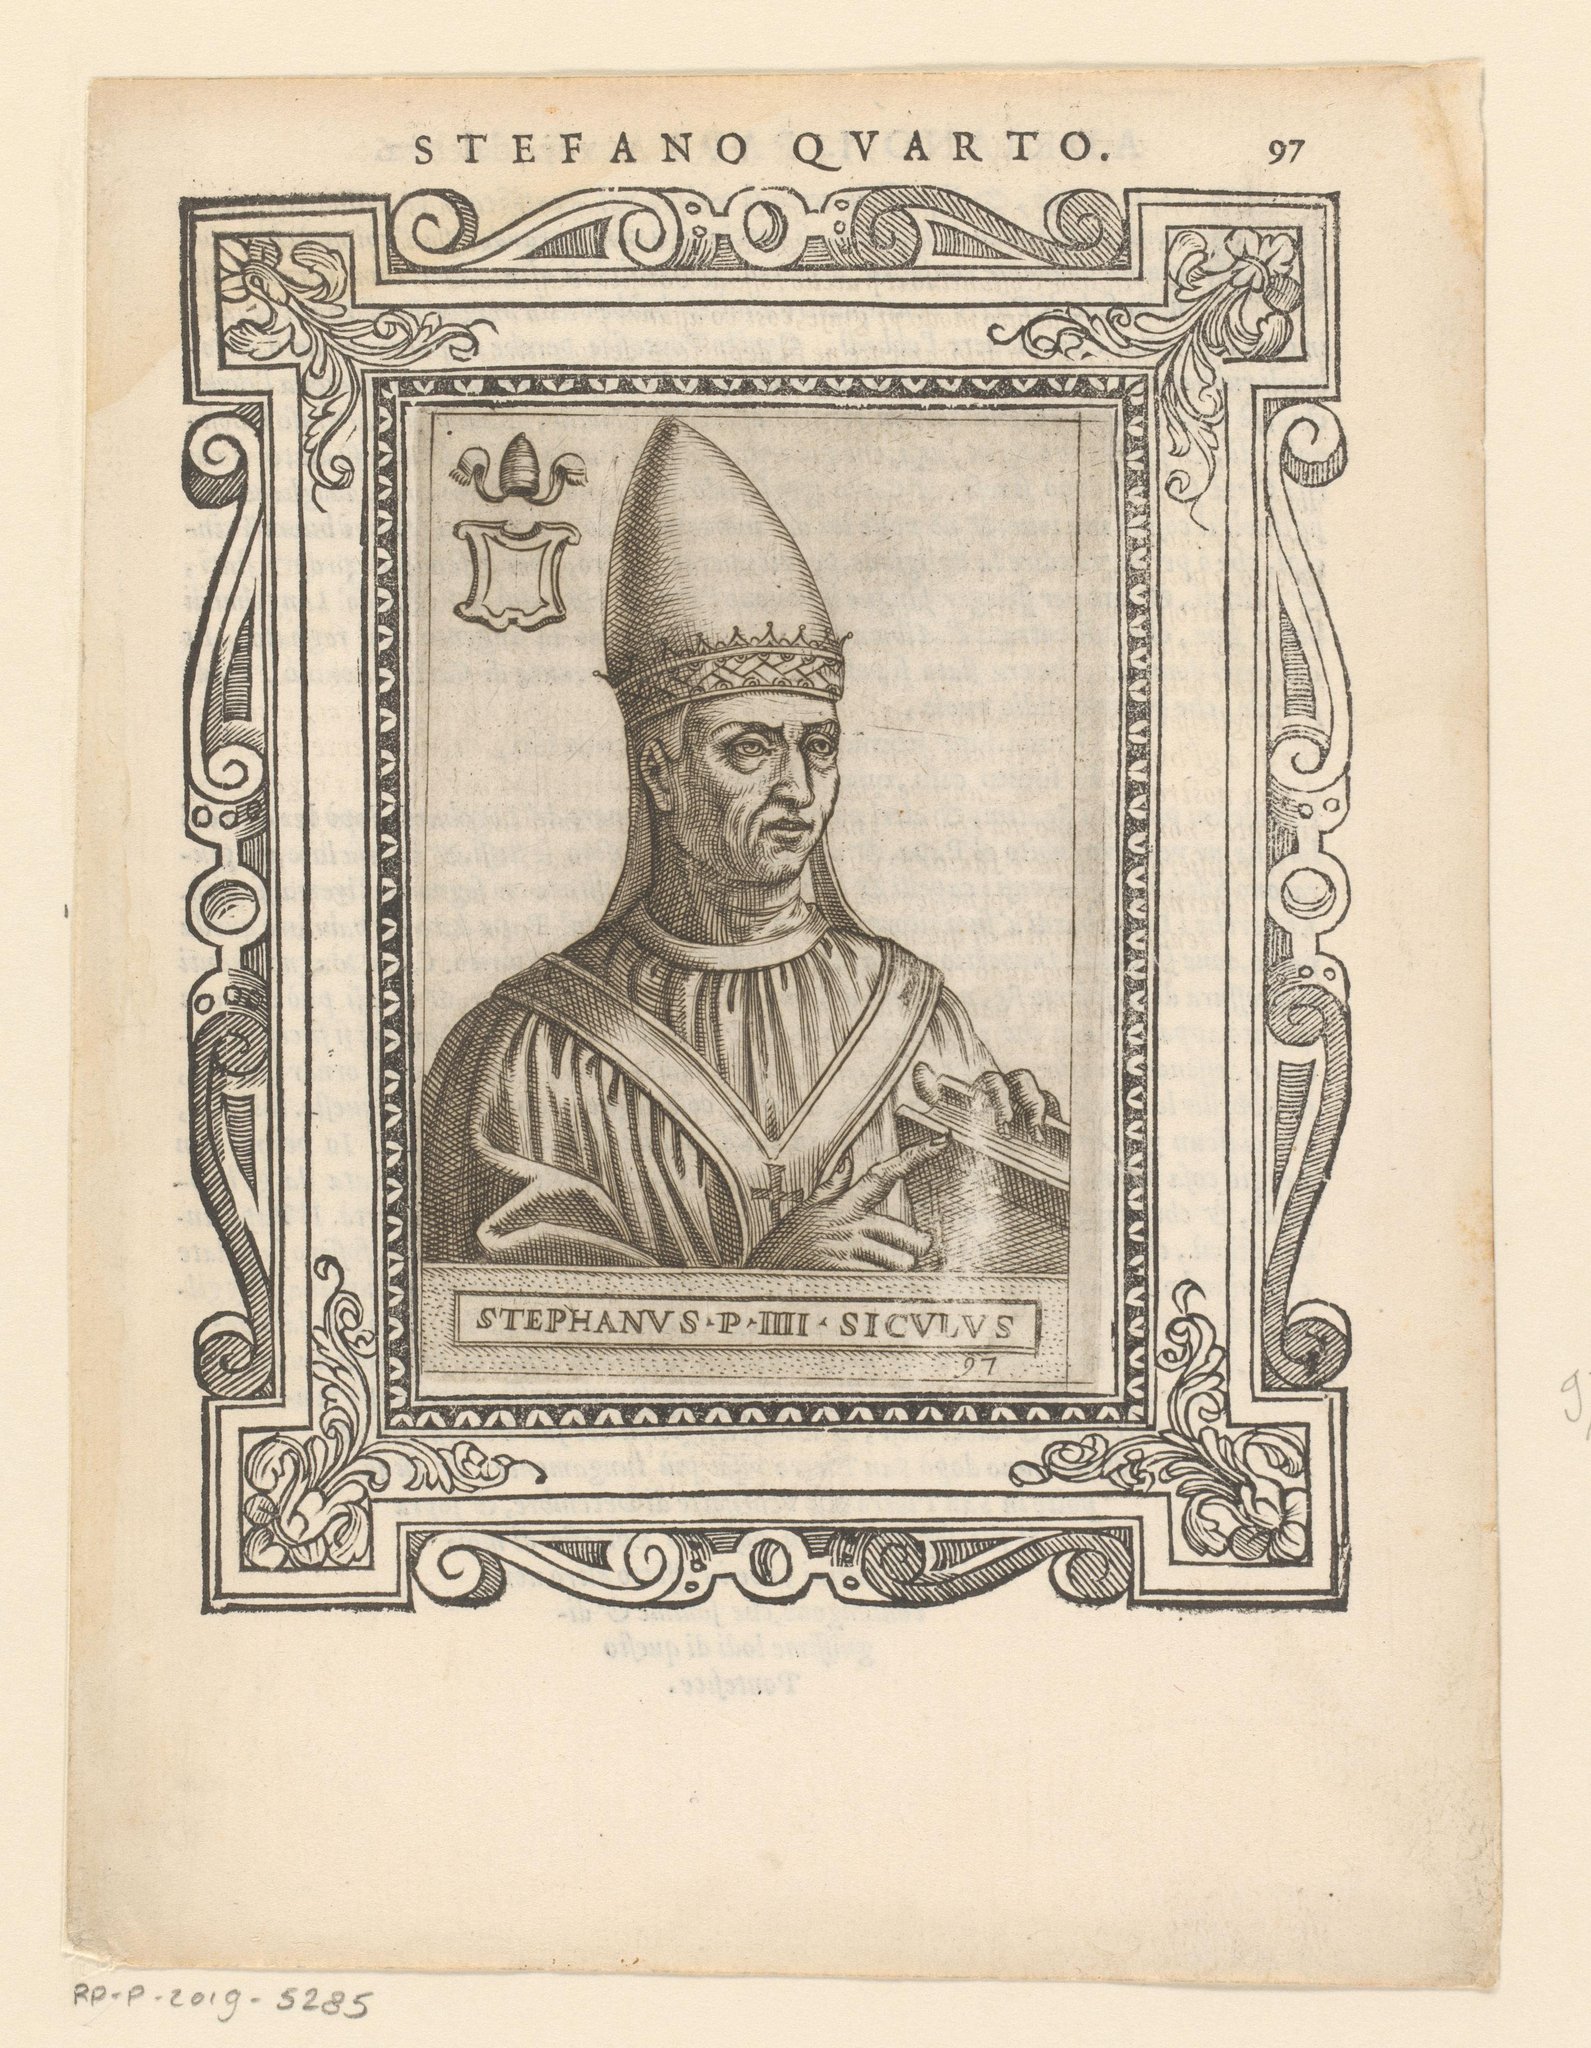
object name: print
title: Portret van paus Stefanus III (IV)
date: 1587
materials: paper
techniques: engraving, letterpress printing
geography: rome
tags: historical persons, pope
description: Prent uit: Ciccarelli, Antonio. Le vite de Pontefici di Antonio Ciccarelli (...). Rome: Domenico Basa, 1587. Prent voor het eerst verschenen in: Cavalieri, Giovanni Battista de'. Pontificum romanorum effigies (...). Rome: Domenico Basa en Francesco Zanetti, 1580. Prent ook gebruikt in latere publicaties.